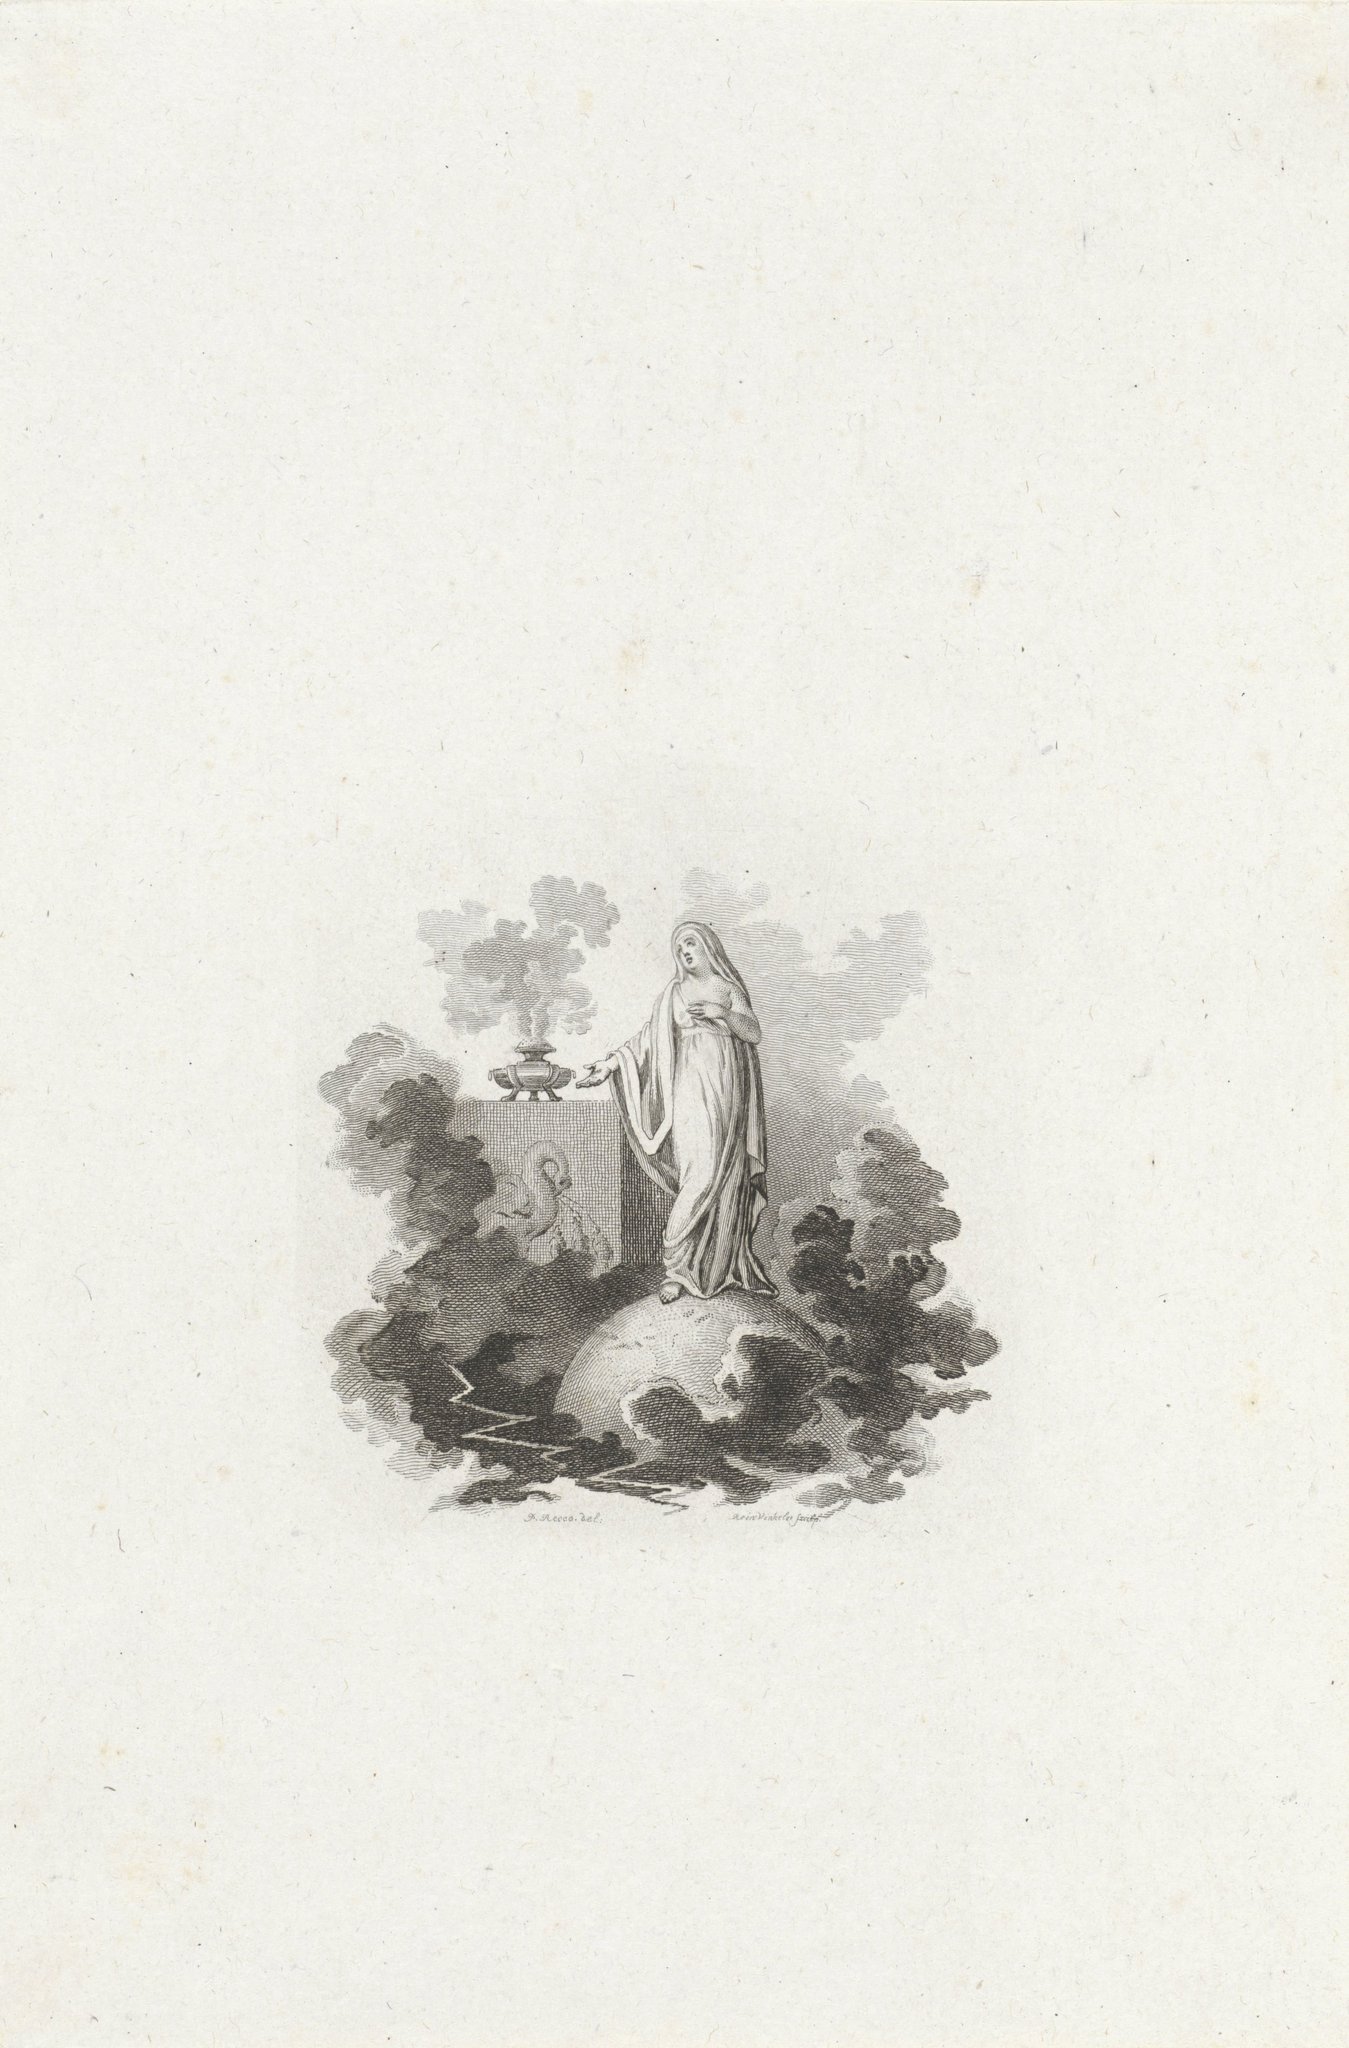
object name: print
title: Vignet met een vrouw op een bol in de wolken bij een wierookvat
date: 1751-1816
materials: paper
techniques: engraving, etching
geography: amsterdam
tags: clouds, incense-burner ~ scents, perfumes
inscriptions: collector's mark: Lugt 240